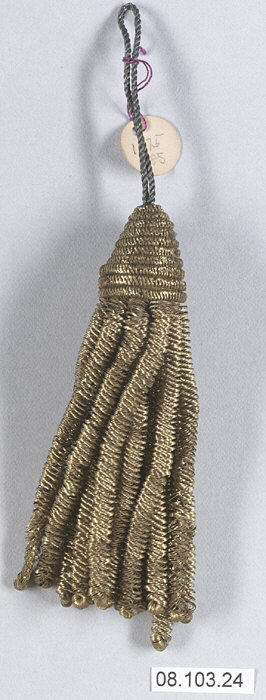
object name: tassel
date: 1701-1900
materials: metal thread